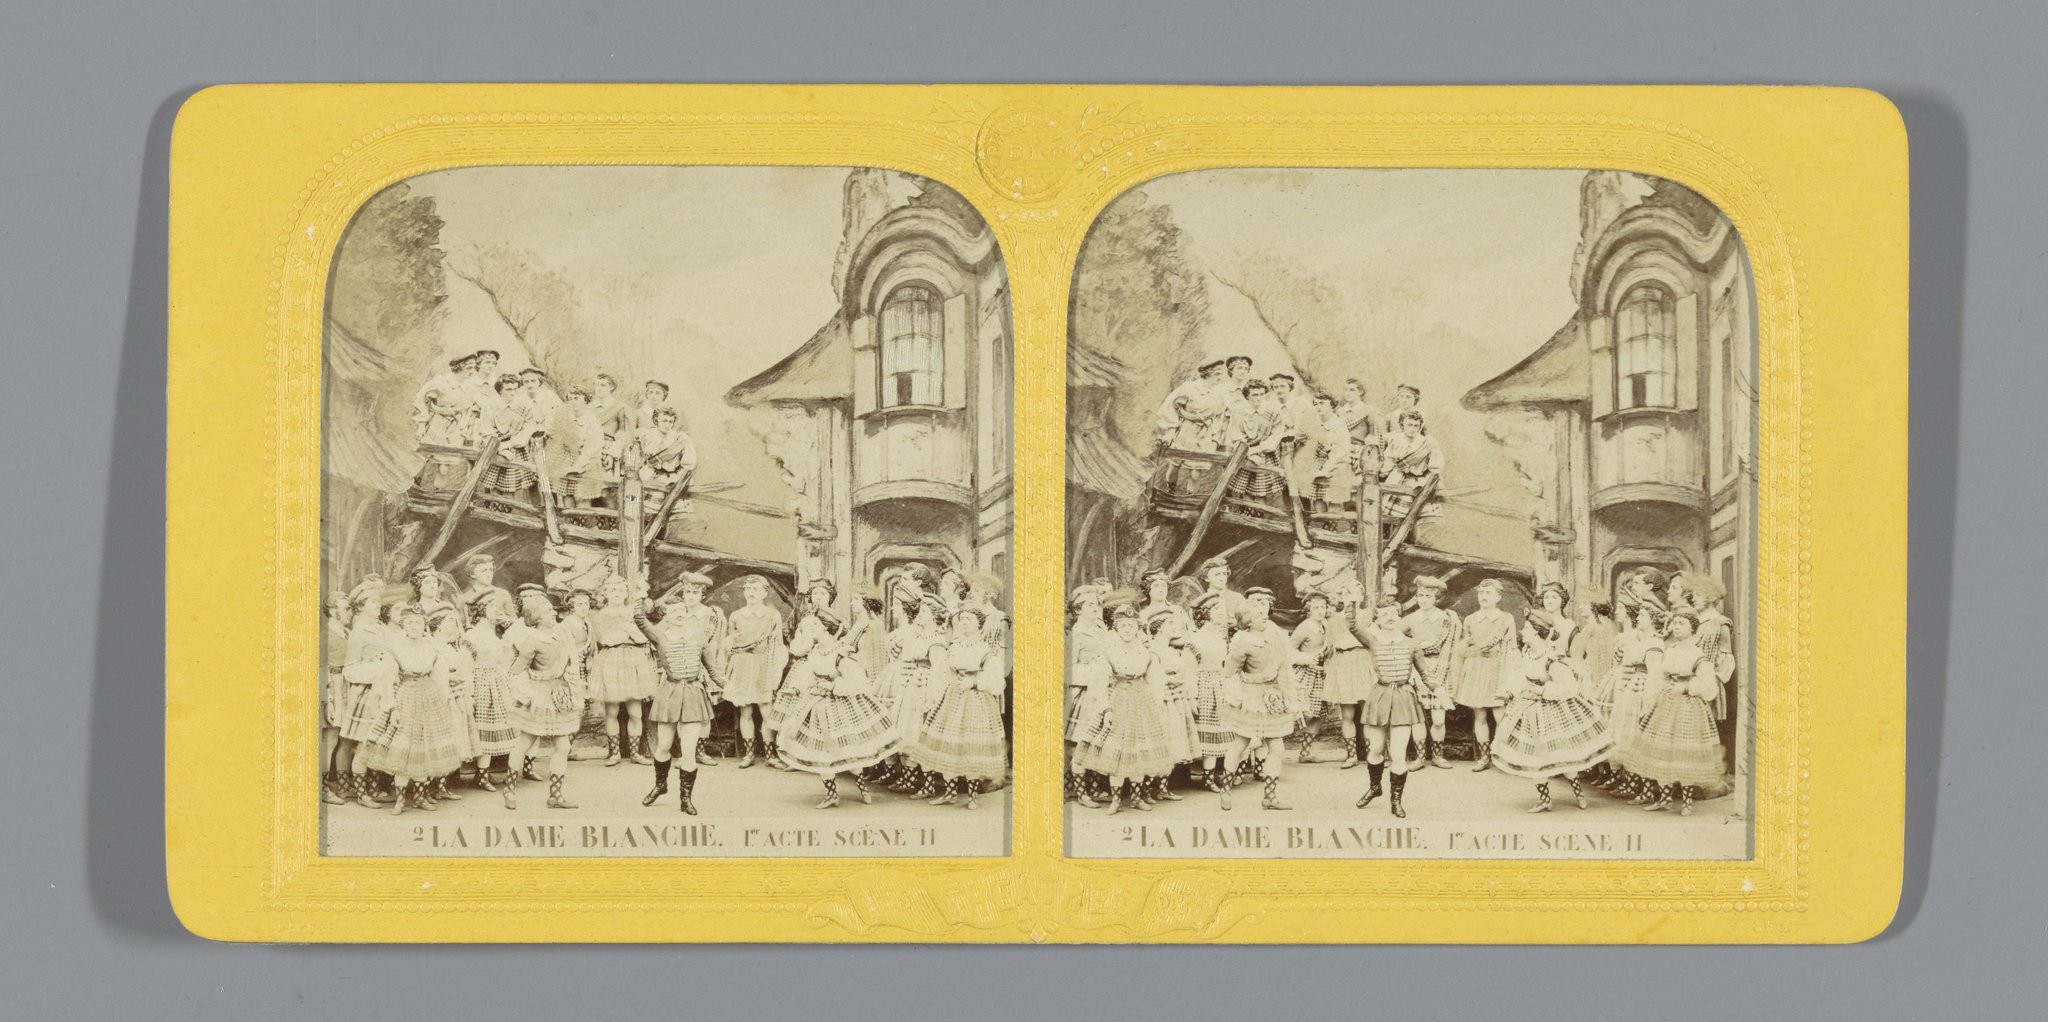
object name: stereograph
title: Stereofoto van het theater in Parijs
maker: Anonymous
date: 1867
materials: cardboard, photographic support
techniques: albumen print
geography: paris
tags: group of actors, troupe; actors on the stage, paris